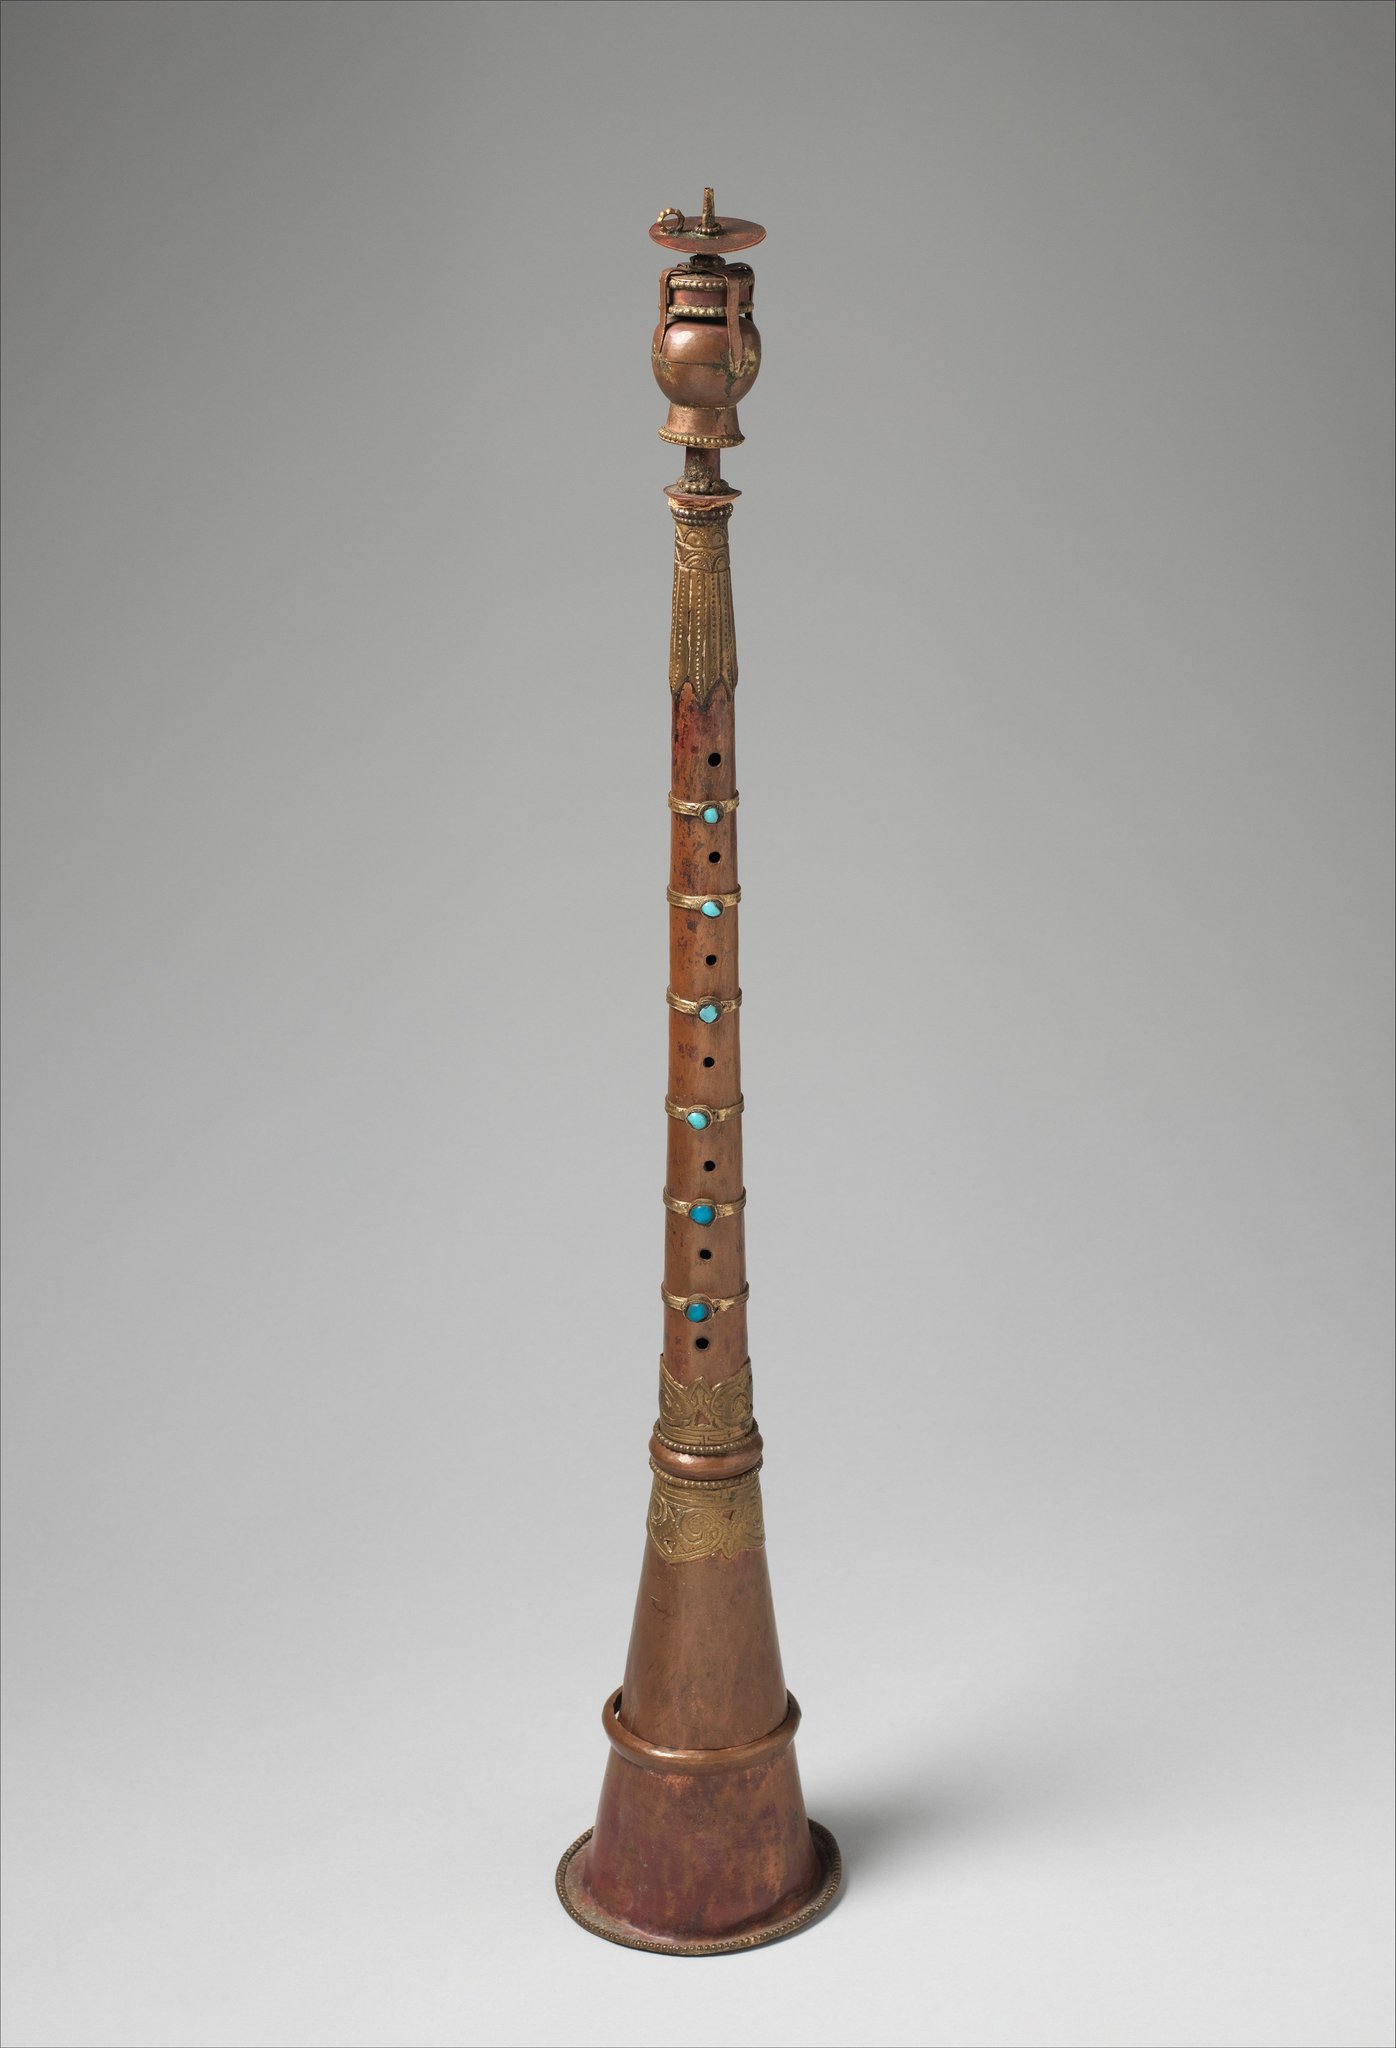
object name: rgya gling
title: Rgya-Gling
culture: tibetan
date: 1801-1900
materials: copper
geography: tibet